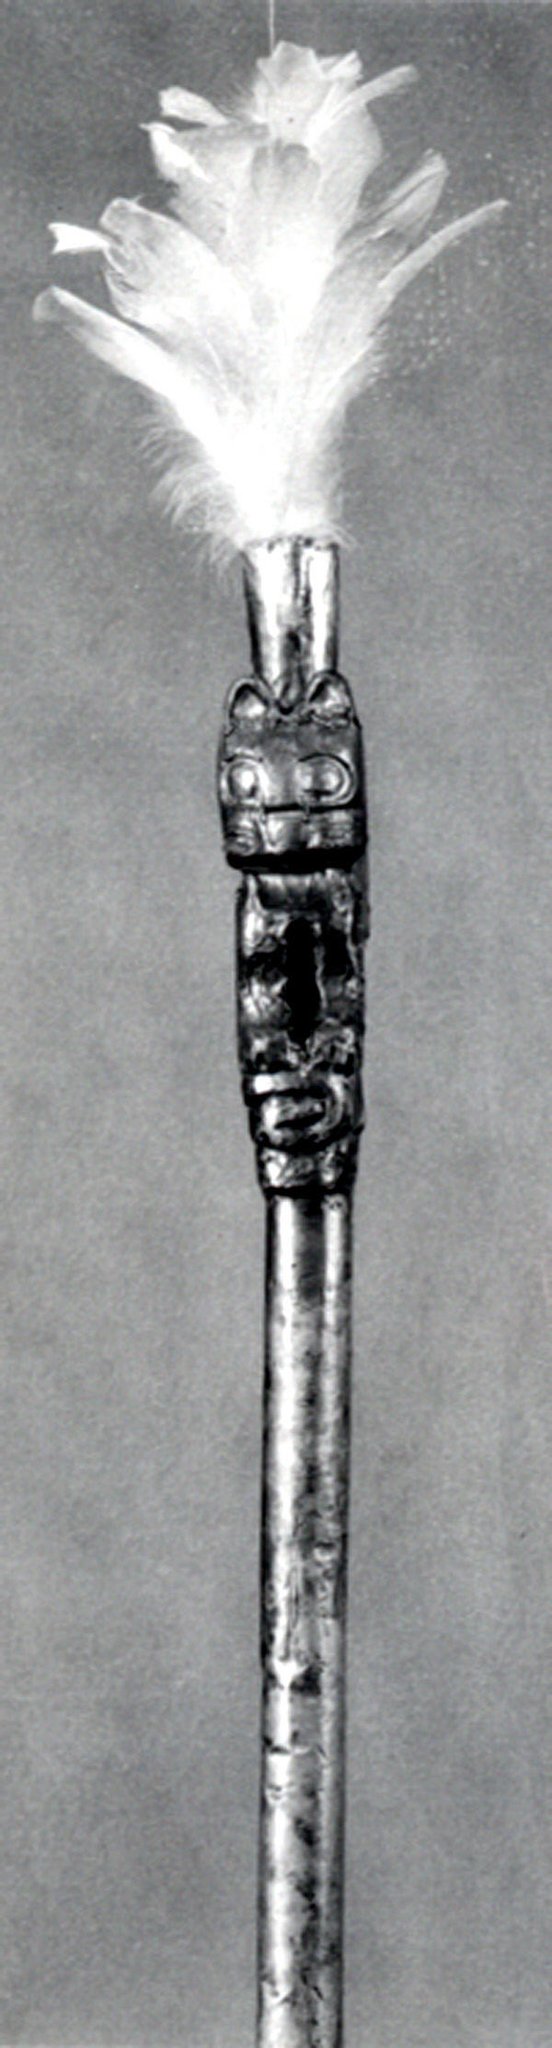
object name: tomb post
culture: inca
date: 1401-1600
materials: feather, silver, wood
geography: peru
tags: animals